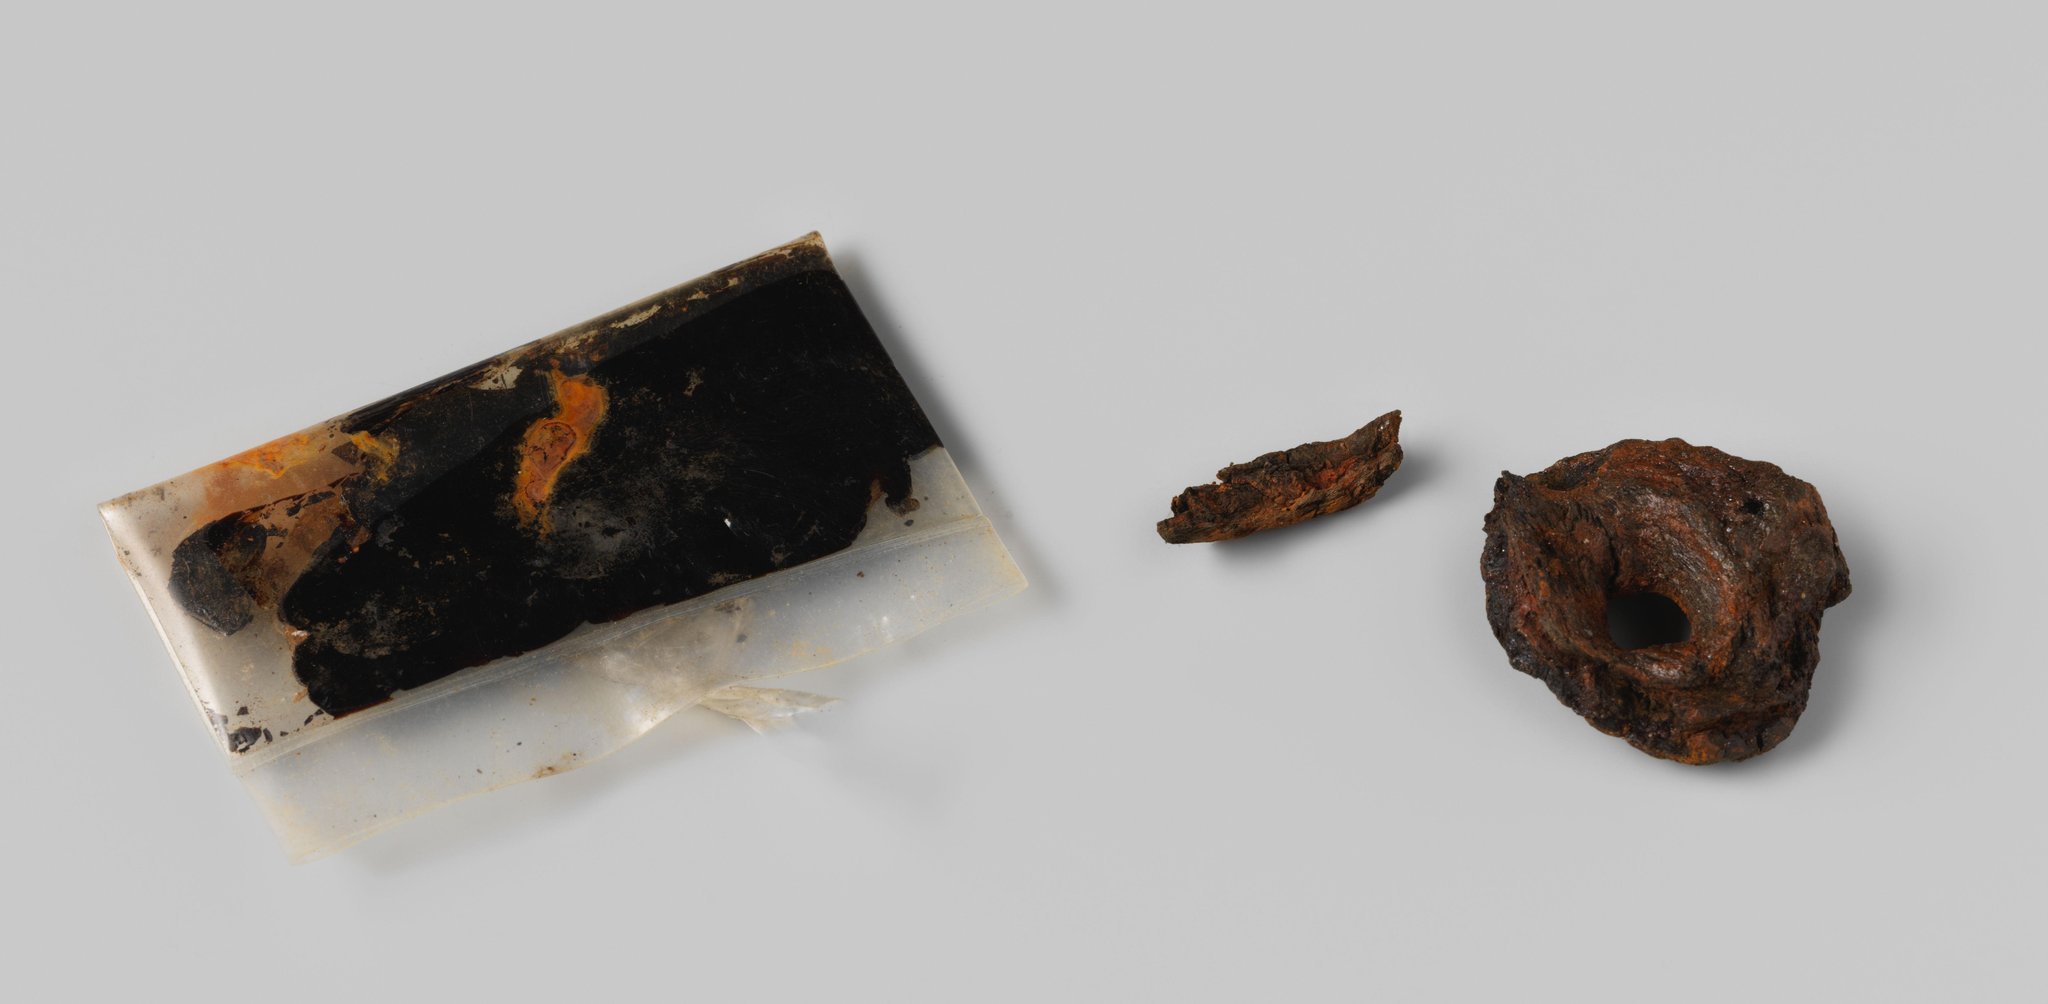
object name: pitch tar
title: Pek en schroefdop uit het wrak van de Oostindiëvaarder Hollandia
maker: Anonymous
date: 1700-1743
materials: iron, pitch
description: Pek met mogelijk metalen object erin en twee fragmenten van een zeer gecorrodeerde schroefdop.